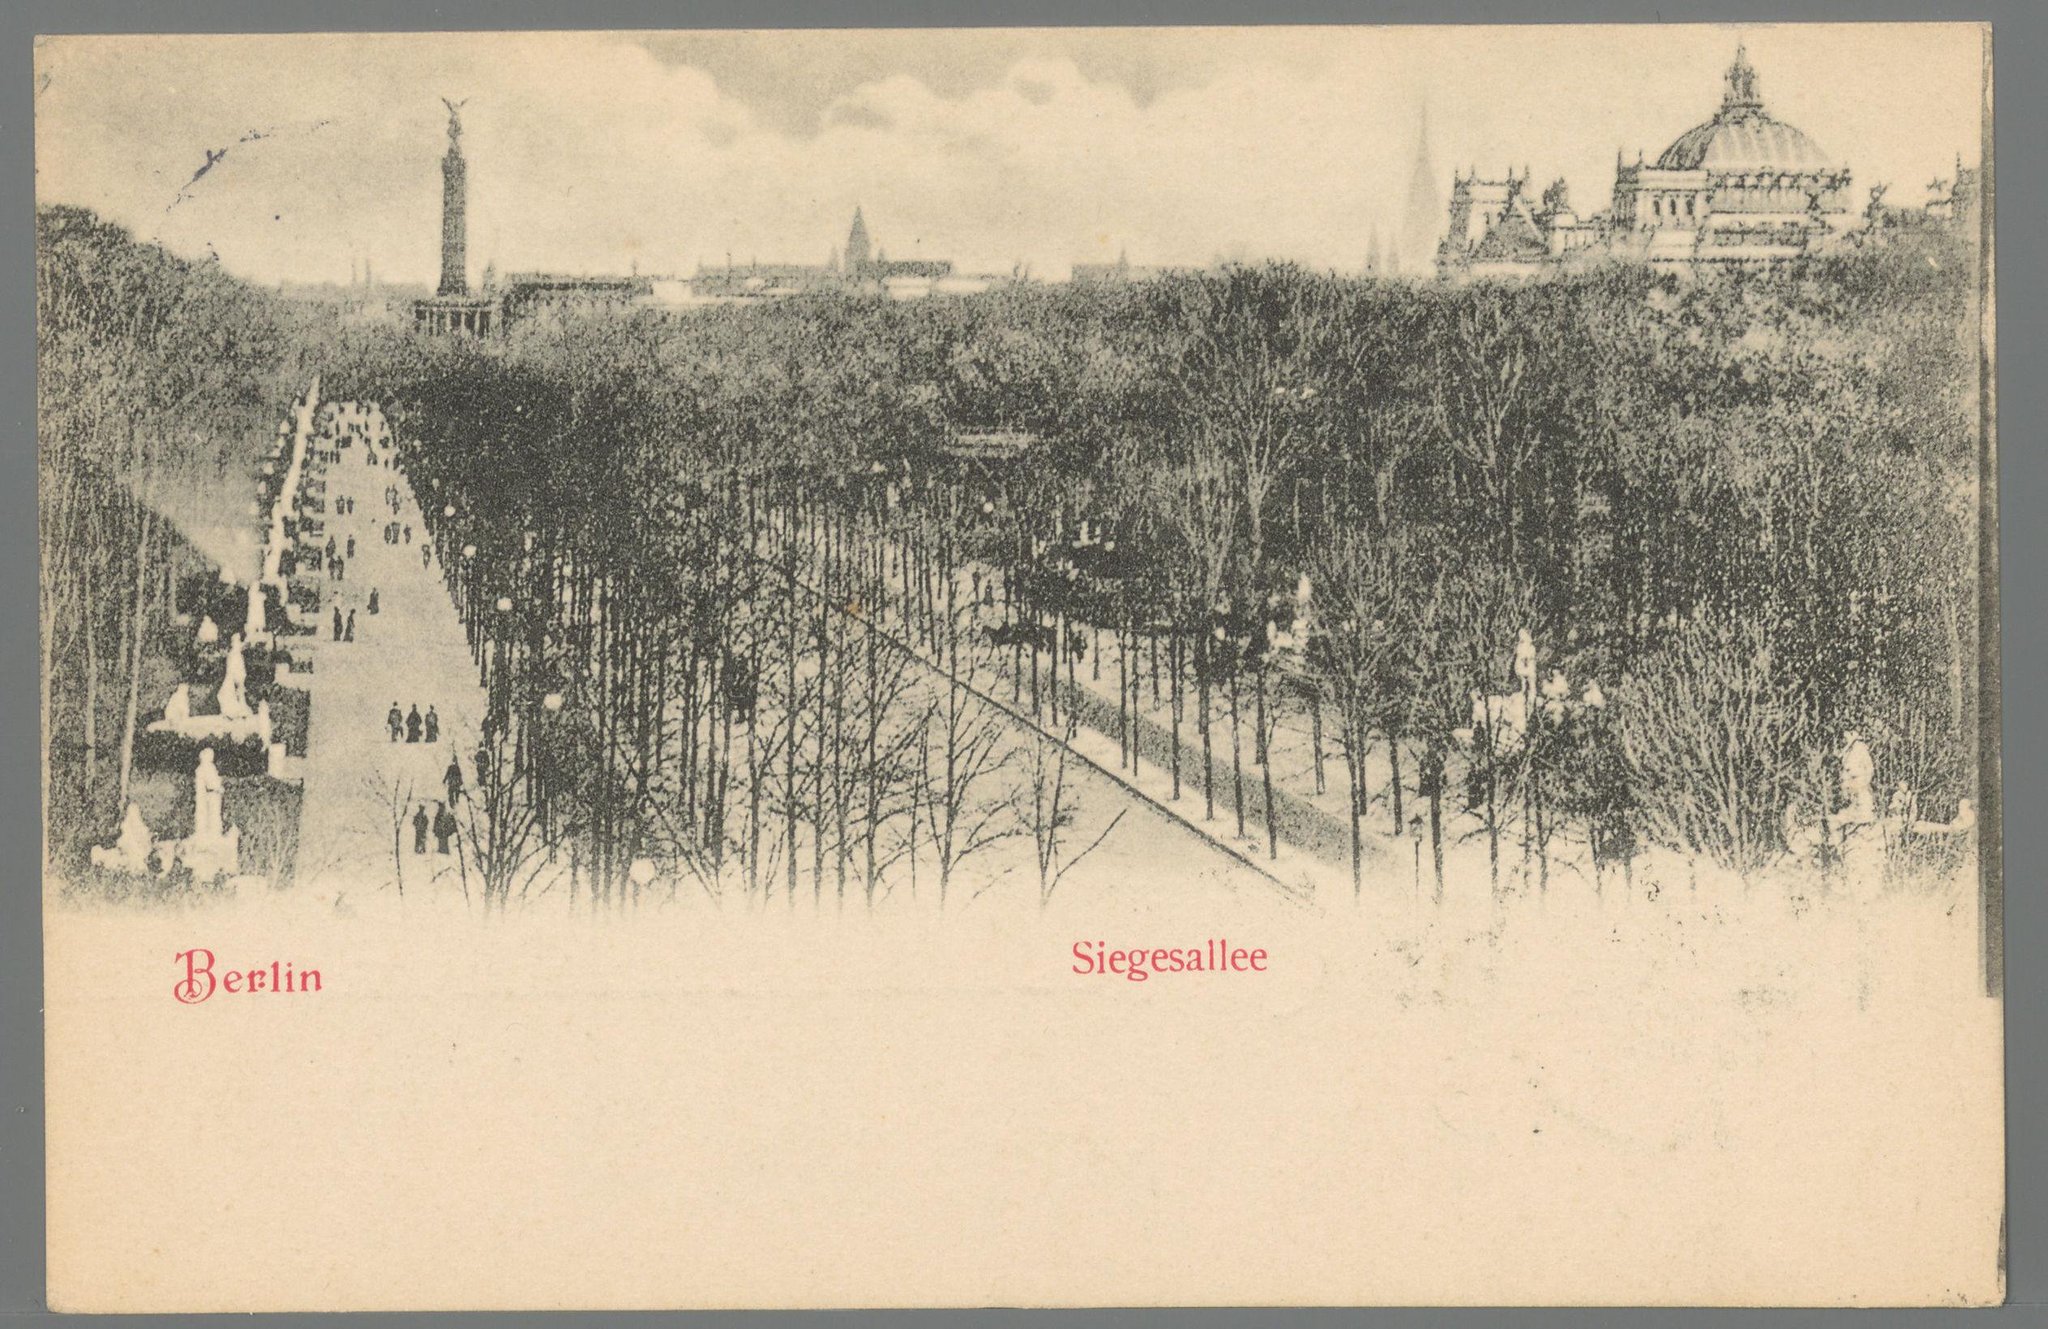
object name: ansichtkaart, prentbriefkaart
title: Berlin. Siegesallee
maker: Anonymous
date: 1901-1903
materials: cardboard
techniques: photograph, writing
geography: berlin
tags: monument, statue, avenue, boulevard, promenade, esplanade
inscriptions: postage stamp